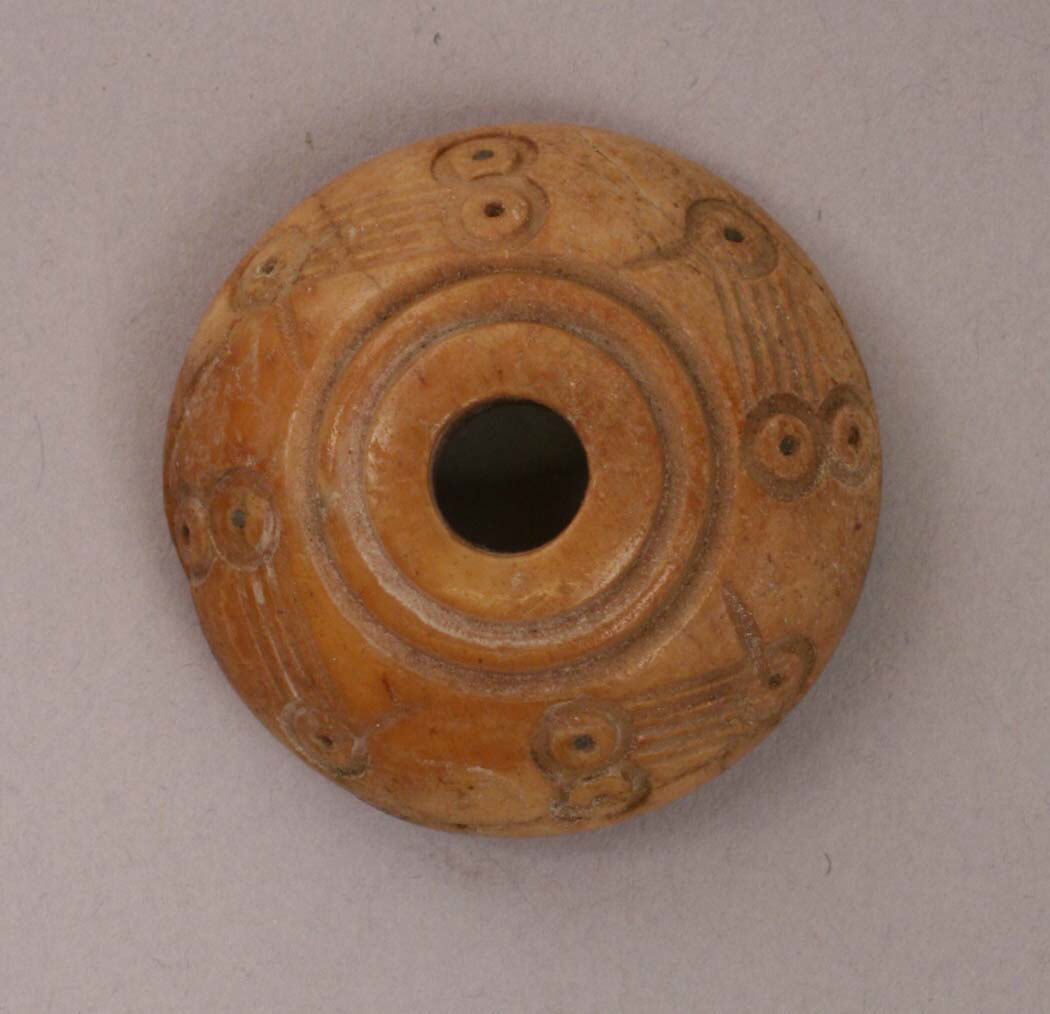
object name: button or spindle whorl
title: Spindle Whorl or Button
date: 201-1200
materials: bone, paint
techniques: incising, inlay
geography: egypt